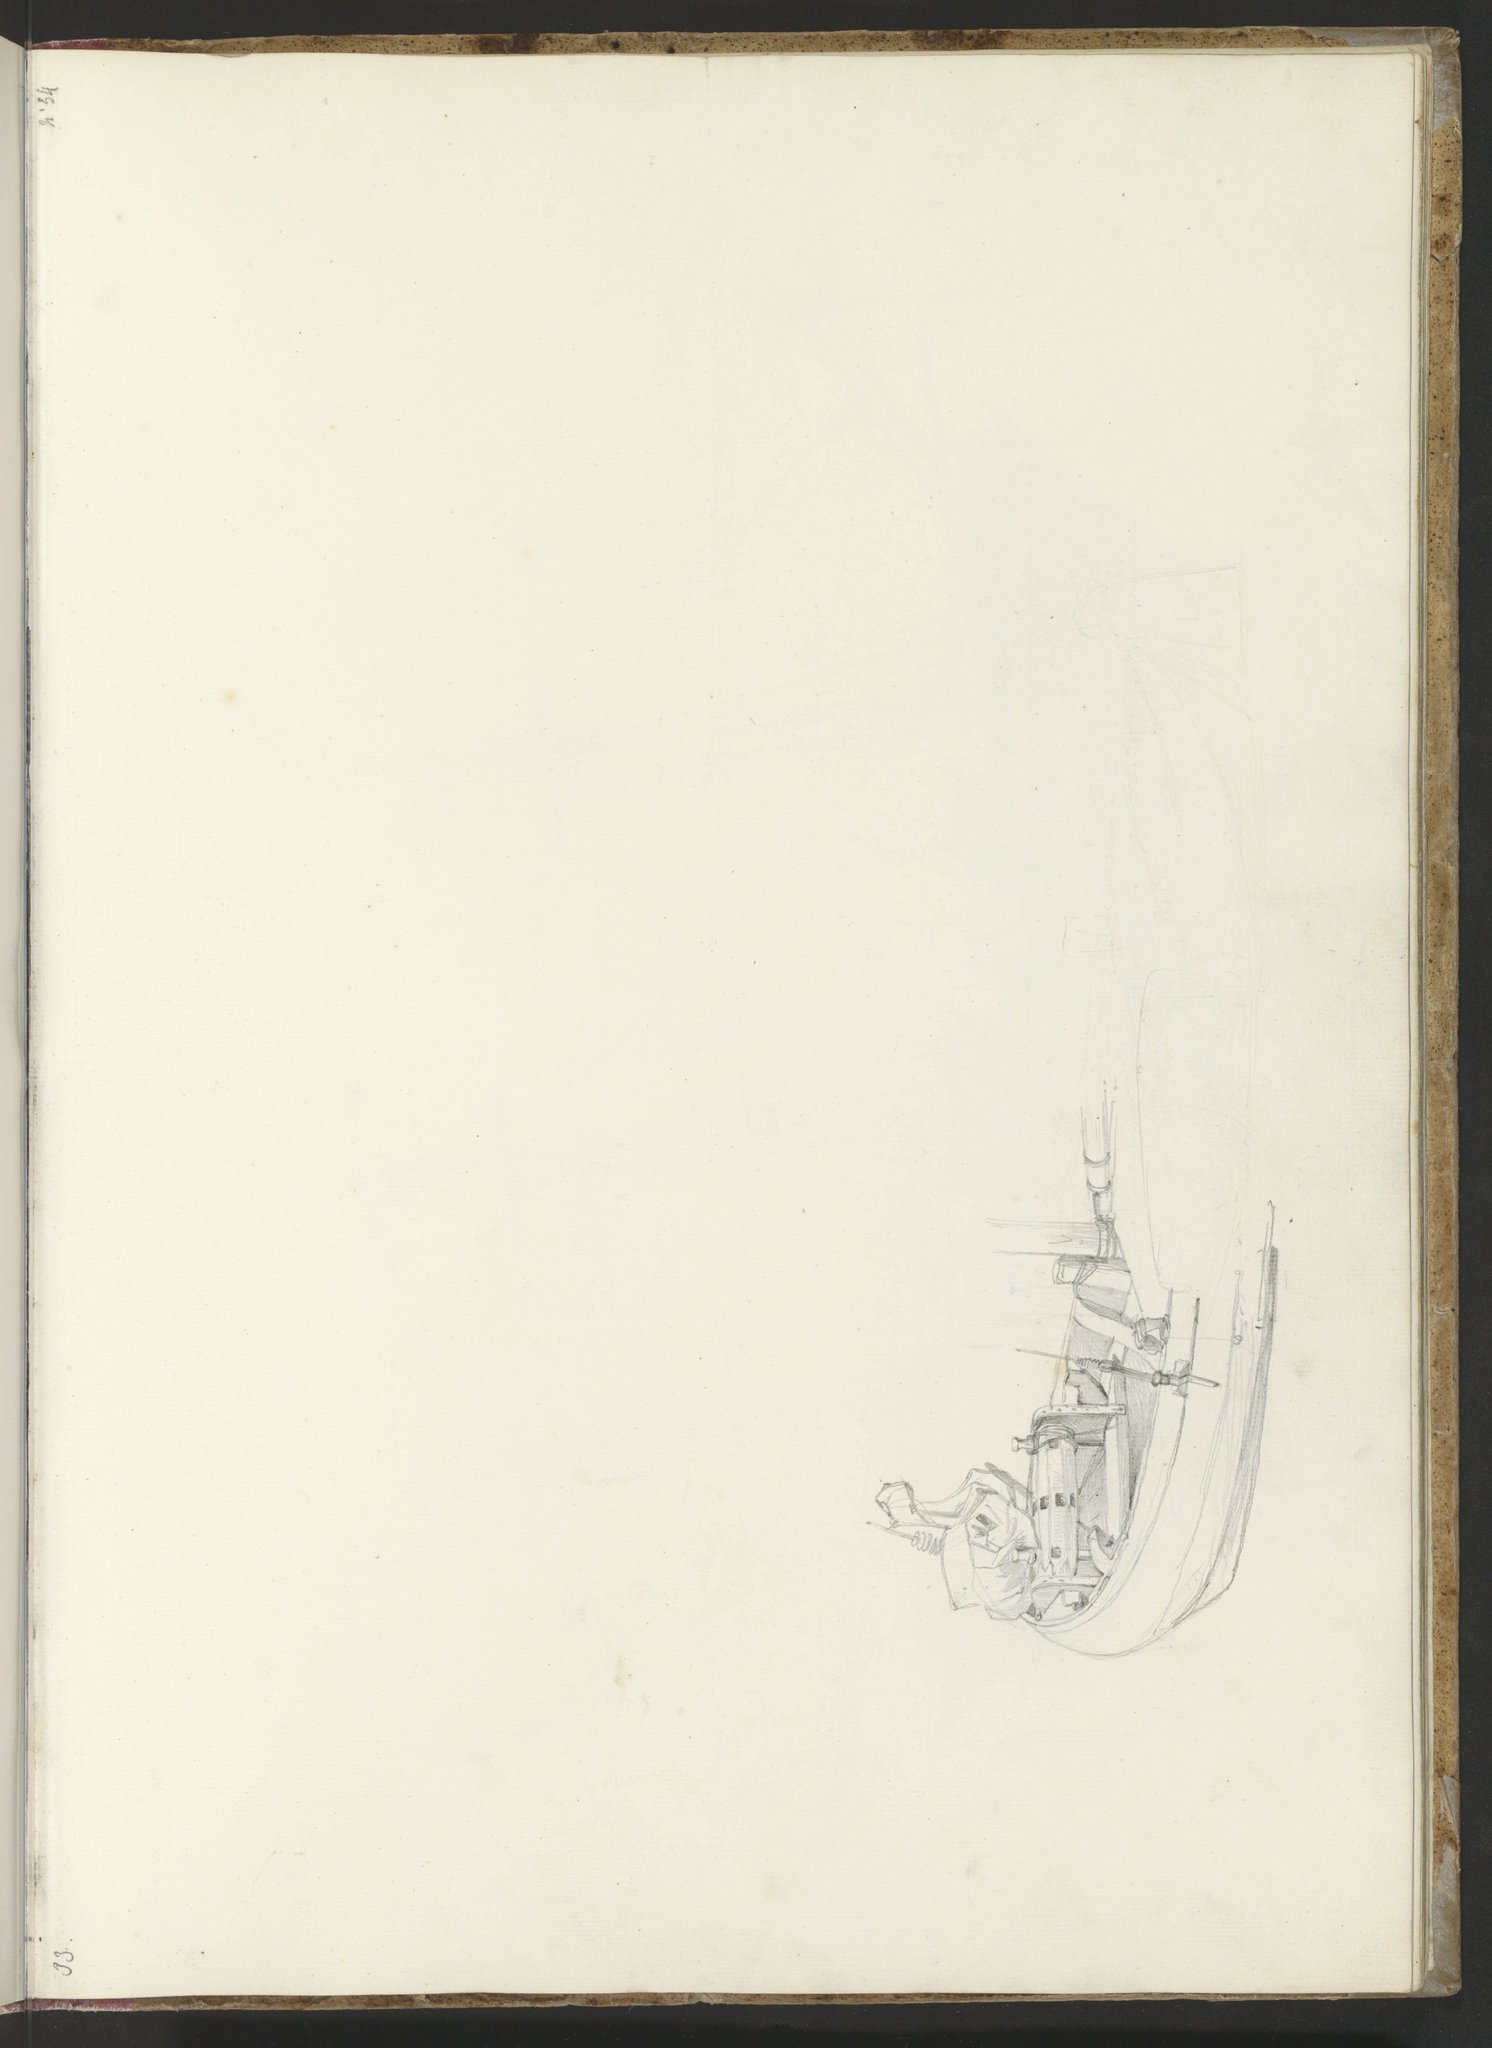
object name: sketchbook leaf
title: Zeilboot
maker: johannes christiaan schotel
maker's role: draughtsman, painter, print maker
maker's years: 1787-1838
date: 1797-1838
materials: paper, pencil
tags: sailing-ship, sailing-boat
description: Blad 33 recto uit een schetsboek met 65 bladen.